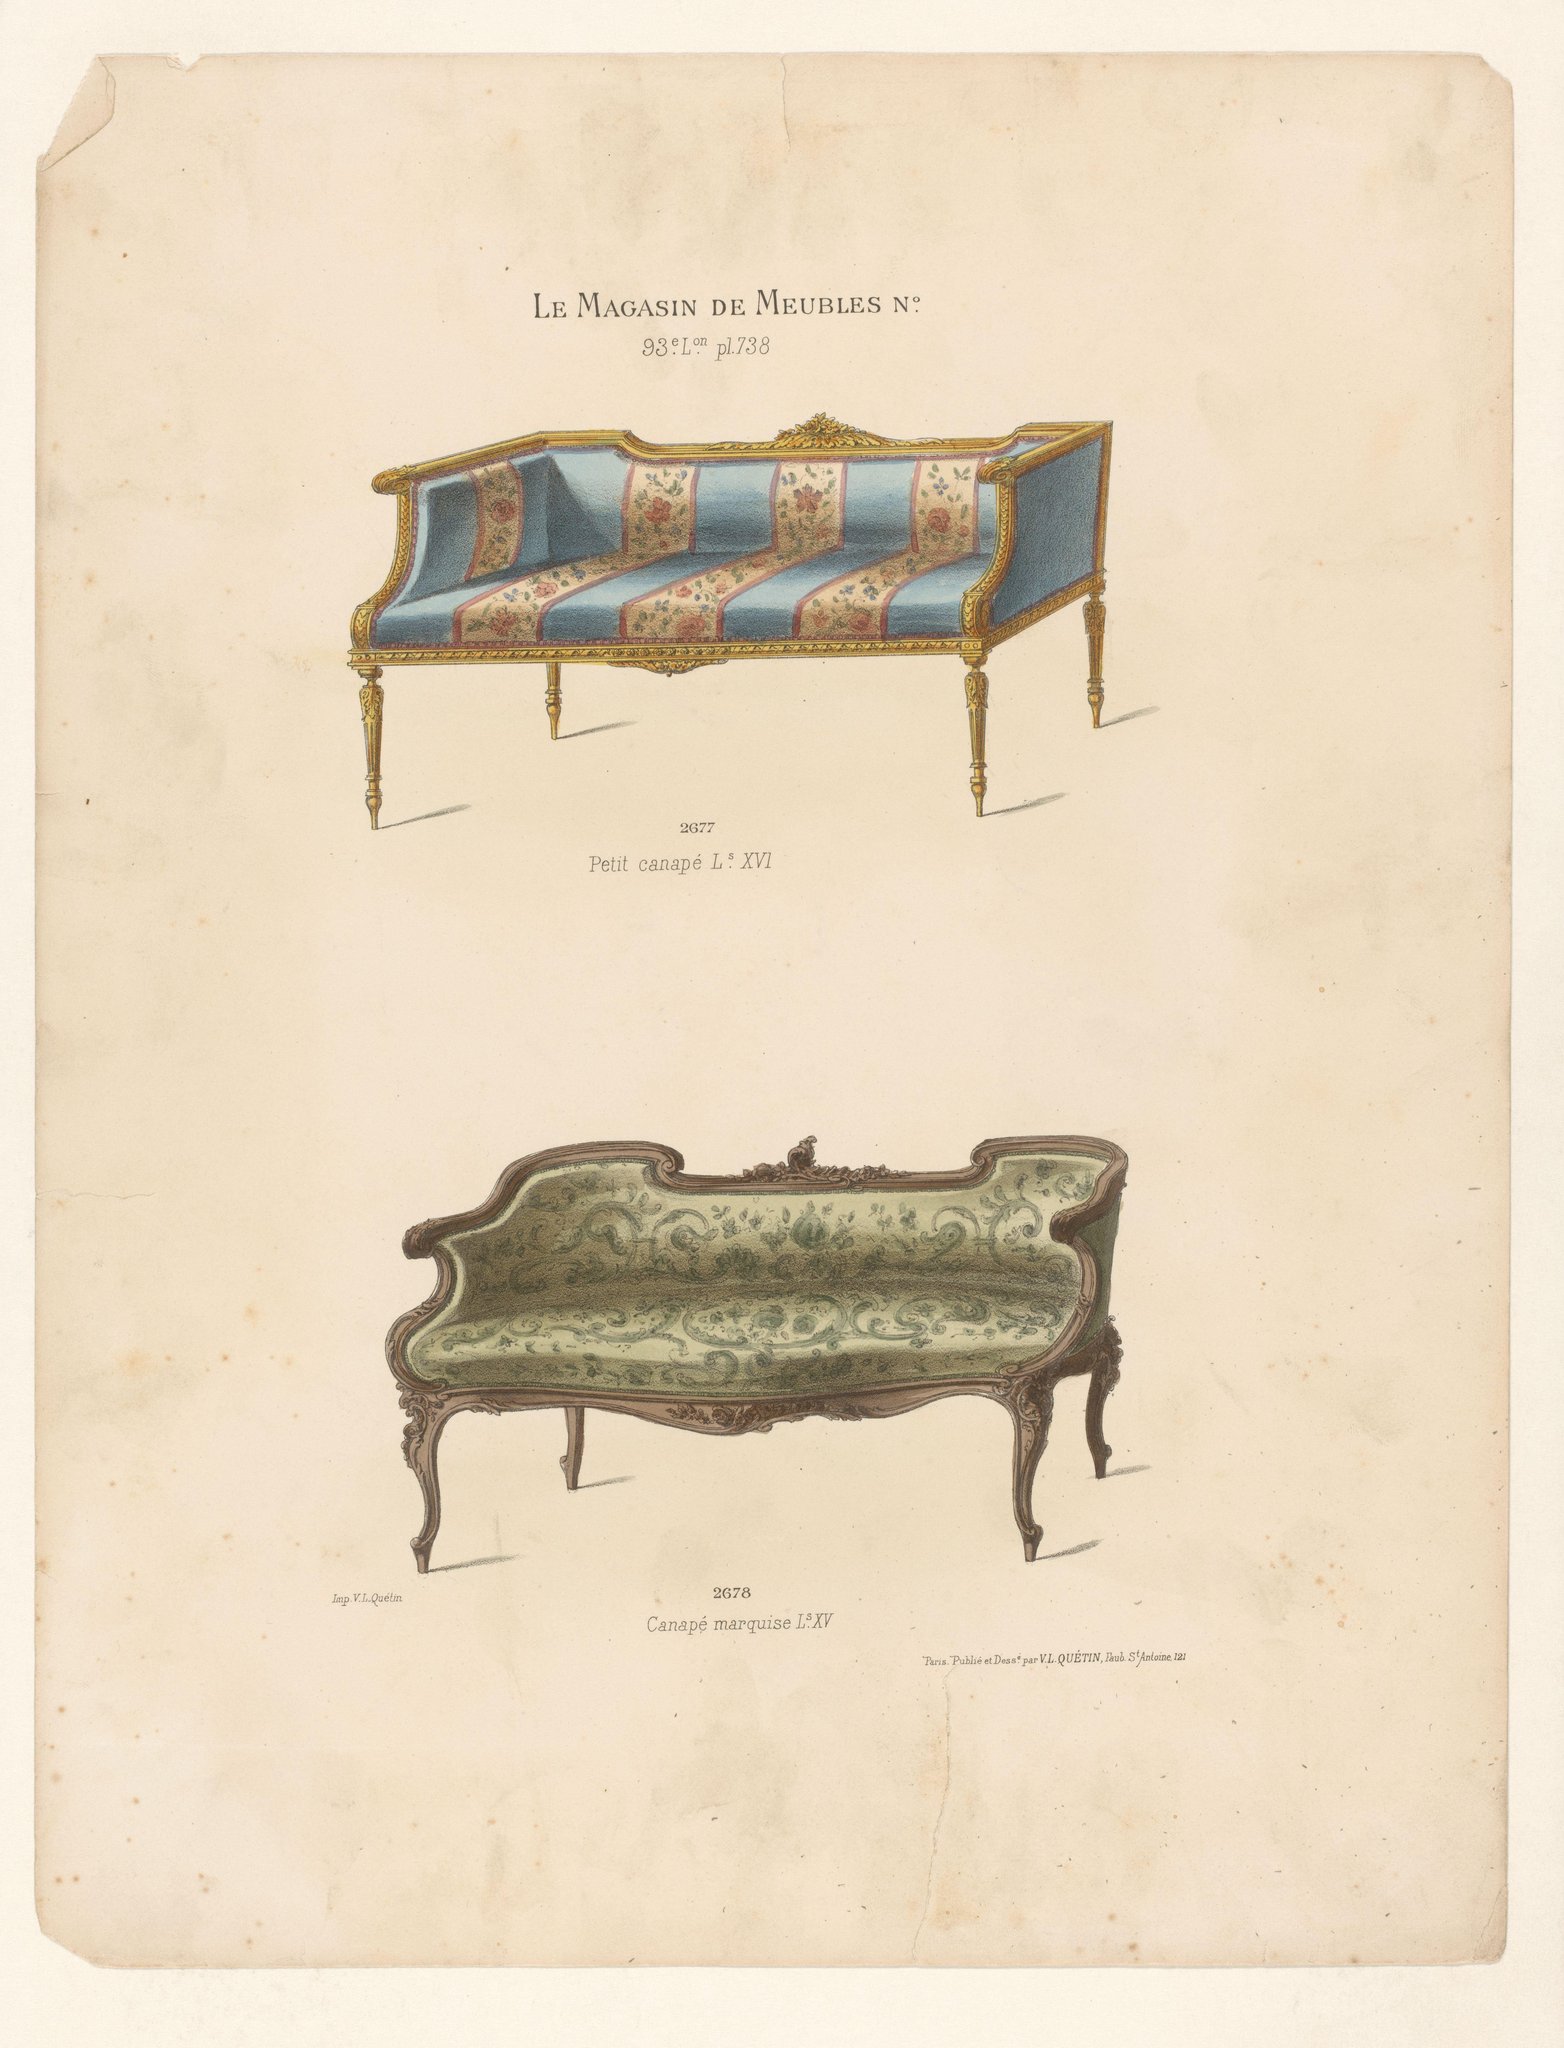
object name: print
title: Twee canapés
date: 1878-1904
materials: paper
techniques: hand coloring, lithograph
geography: paris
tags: seating furniture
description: Twee canapés in de stijlen van Lodewijk XVI en Lodewijk XV. Prent uit 93e Livraison.